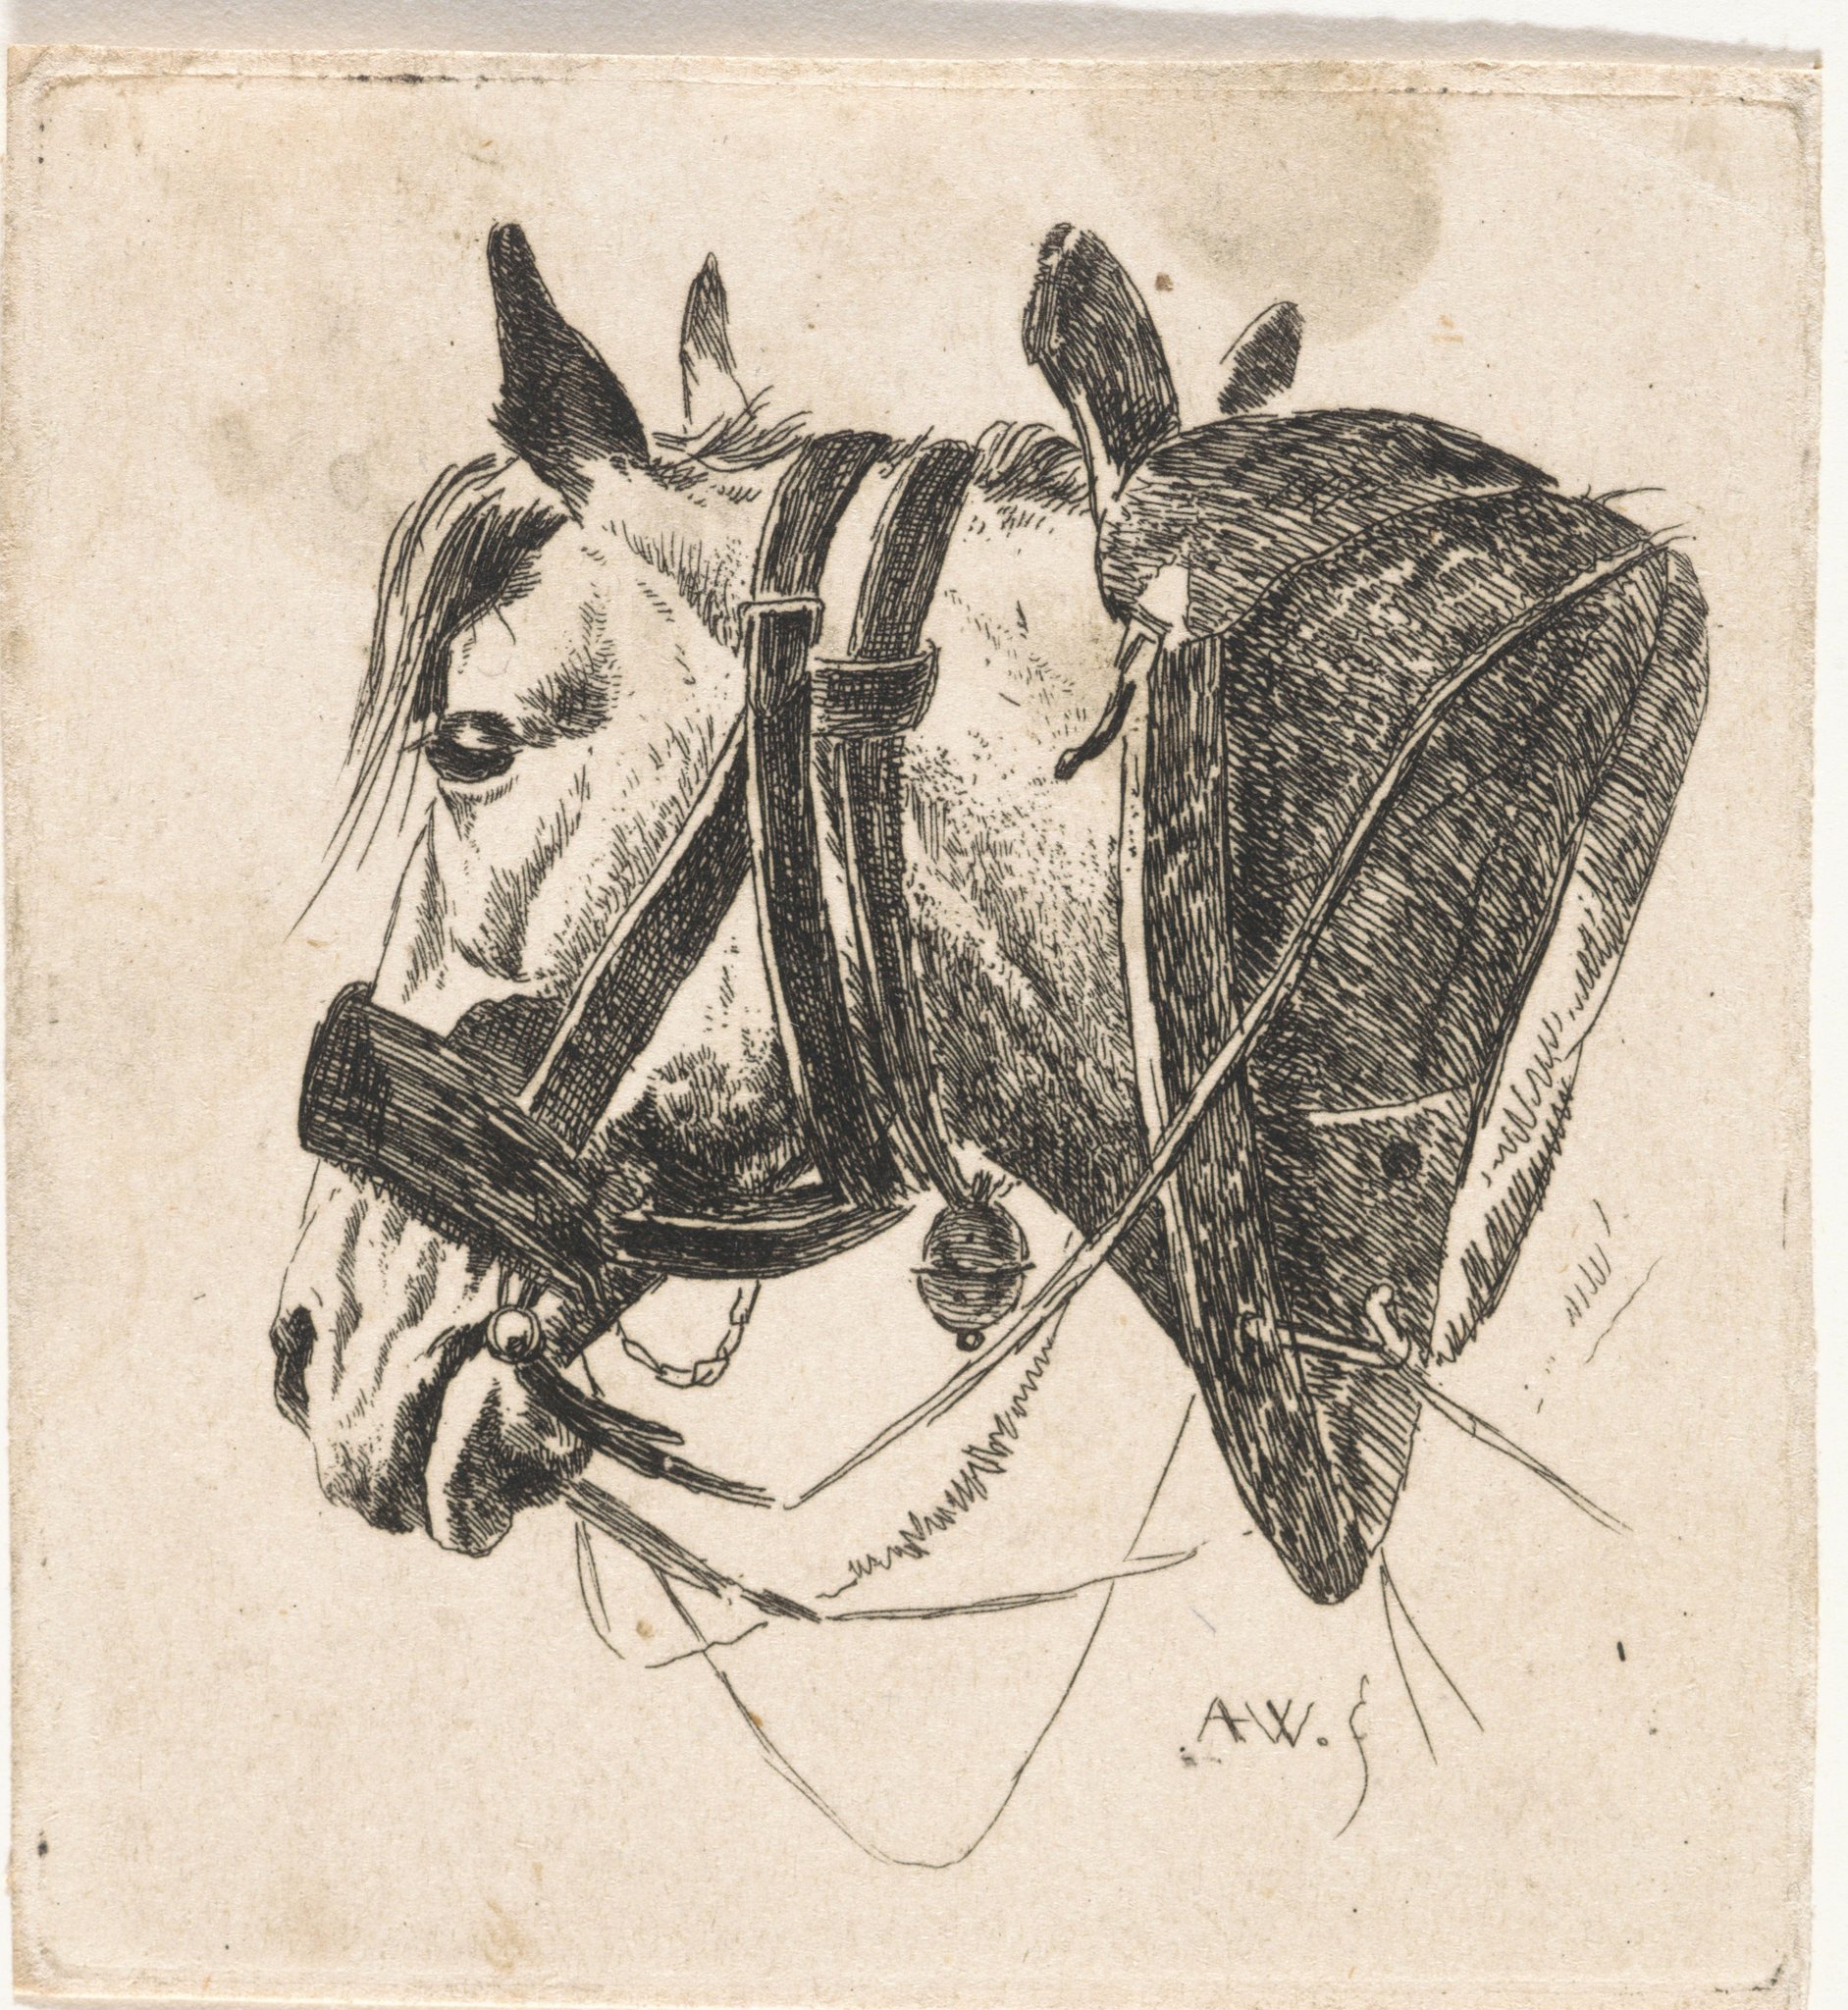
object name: print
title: Paardenhoofd met een hoofdstel met bel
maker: abraham hendrik winter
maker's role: painter, print maker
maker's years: 1800-1861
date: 1815-1860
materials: paper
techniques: etching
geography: utrecht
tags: horse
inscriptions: collector's mark: Lugt 2228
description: Paardenhoofd naar links met een hoofdstel met bel en een gareel.